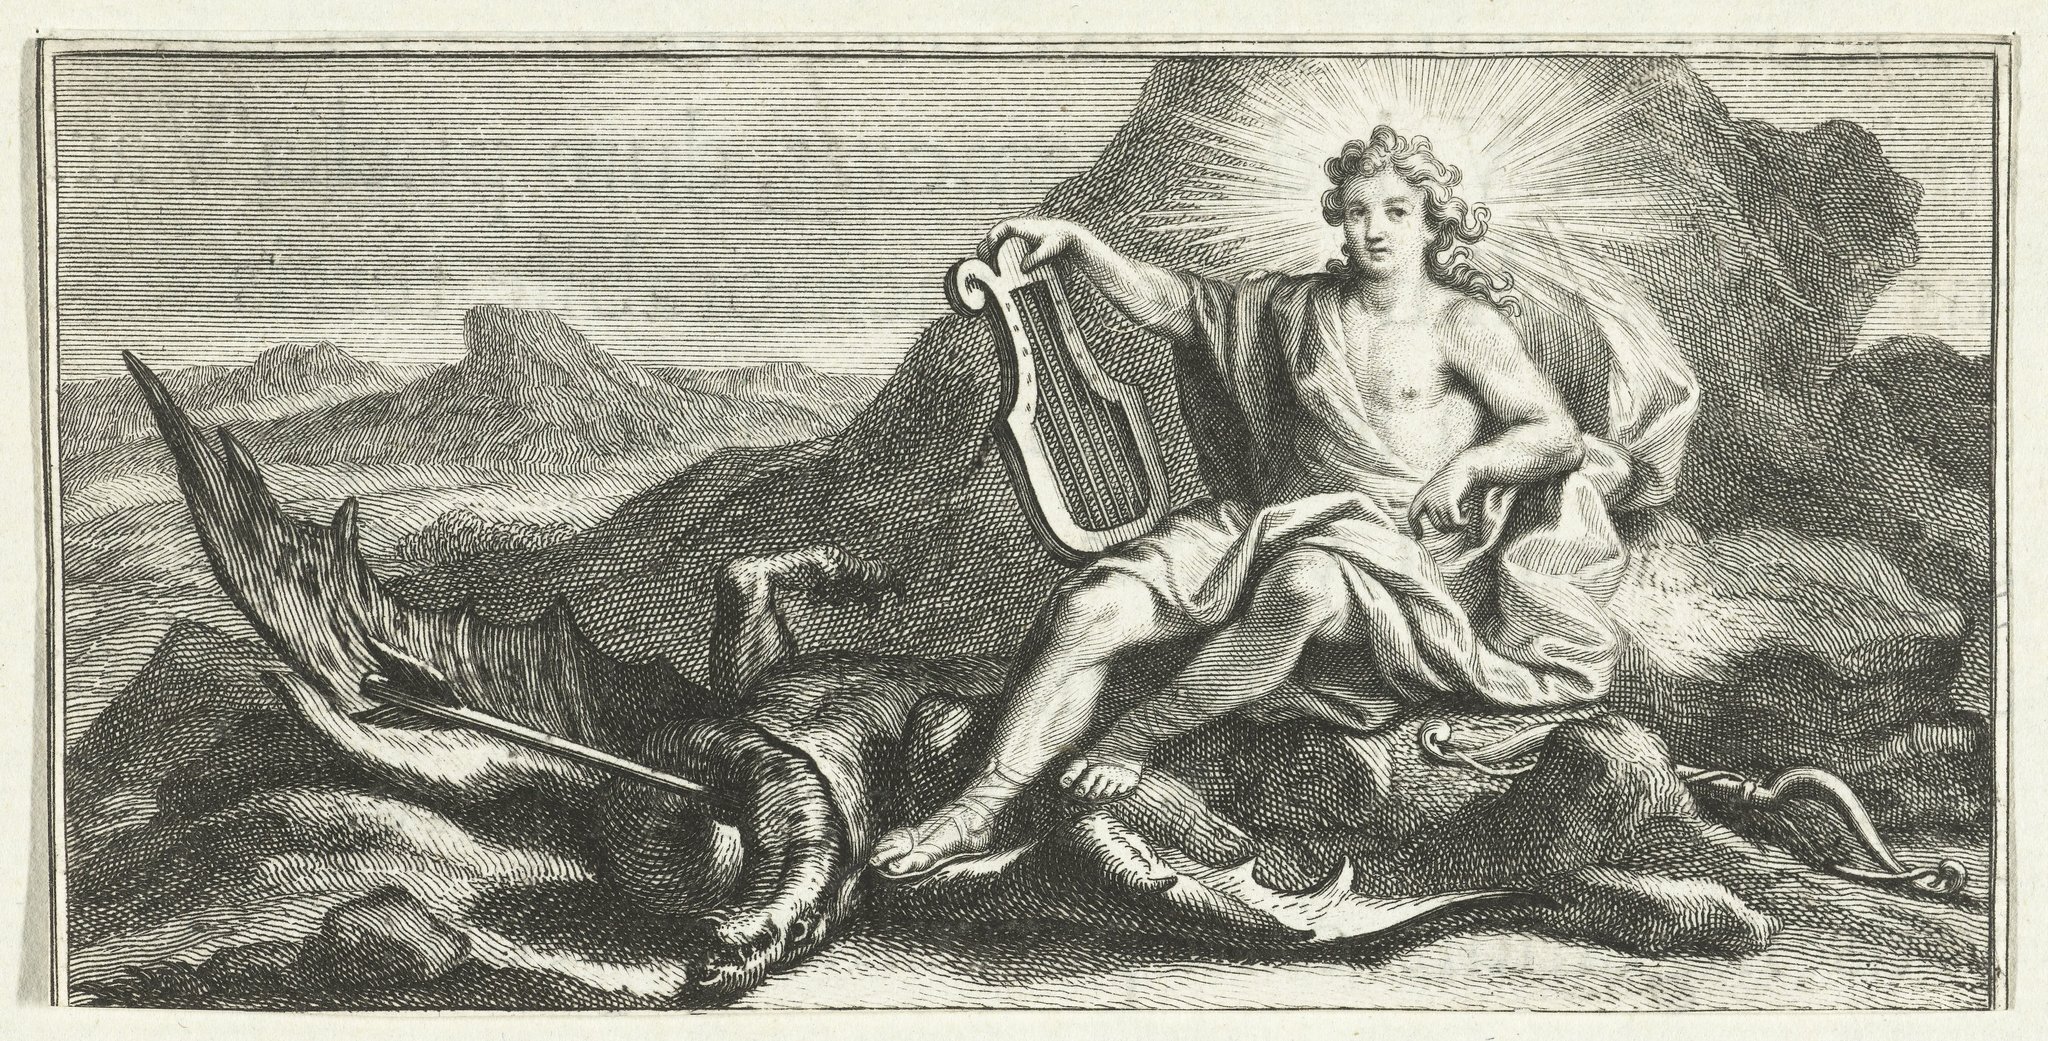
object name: print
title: Apollo verslaat Python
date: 1666-1707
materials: paper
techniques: engraving, etching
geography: france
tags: apollo shoots python, the dragon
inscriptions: collector's mark: Lugt 240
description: Apollo met harp zit bij de door een pijl getroffen draak Python, naast hem ligt zijn boog. De achterkant van de prent is bedrukt met tekst in Latijn.